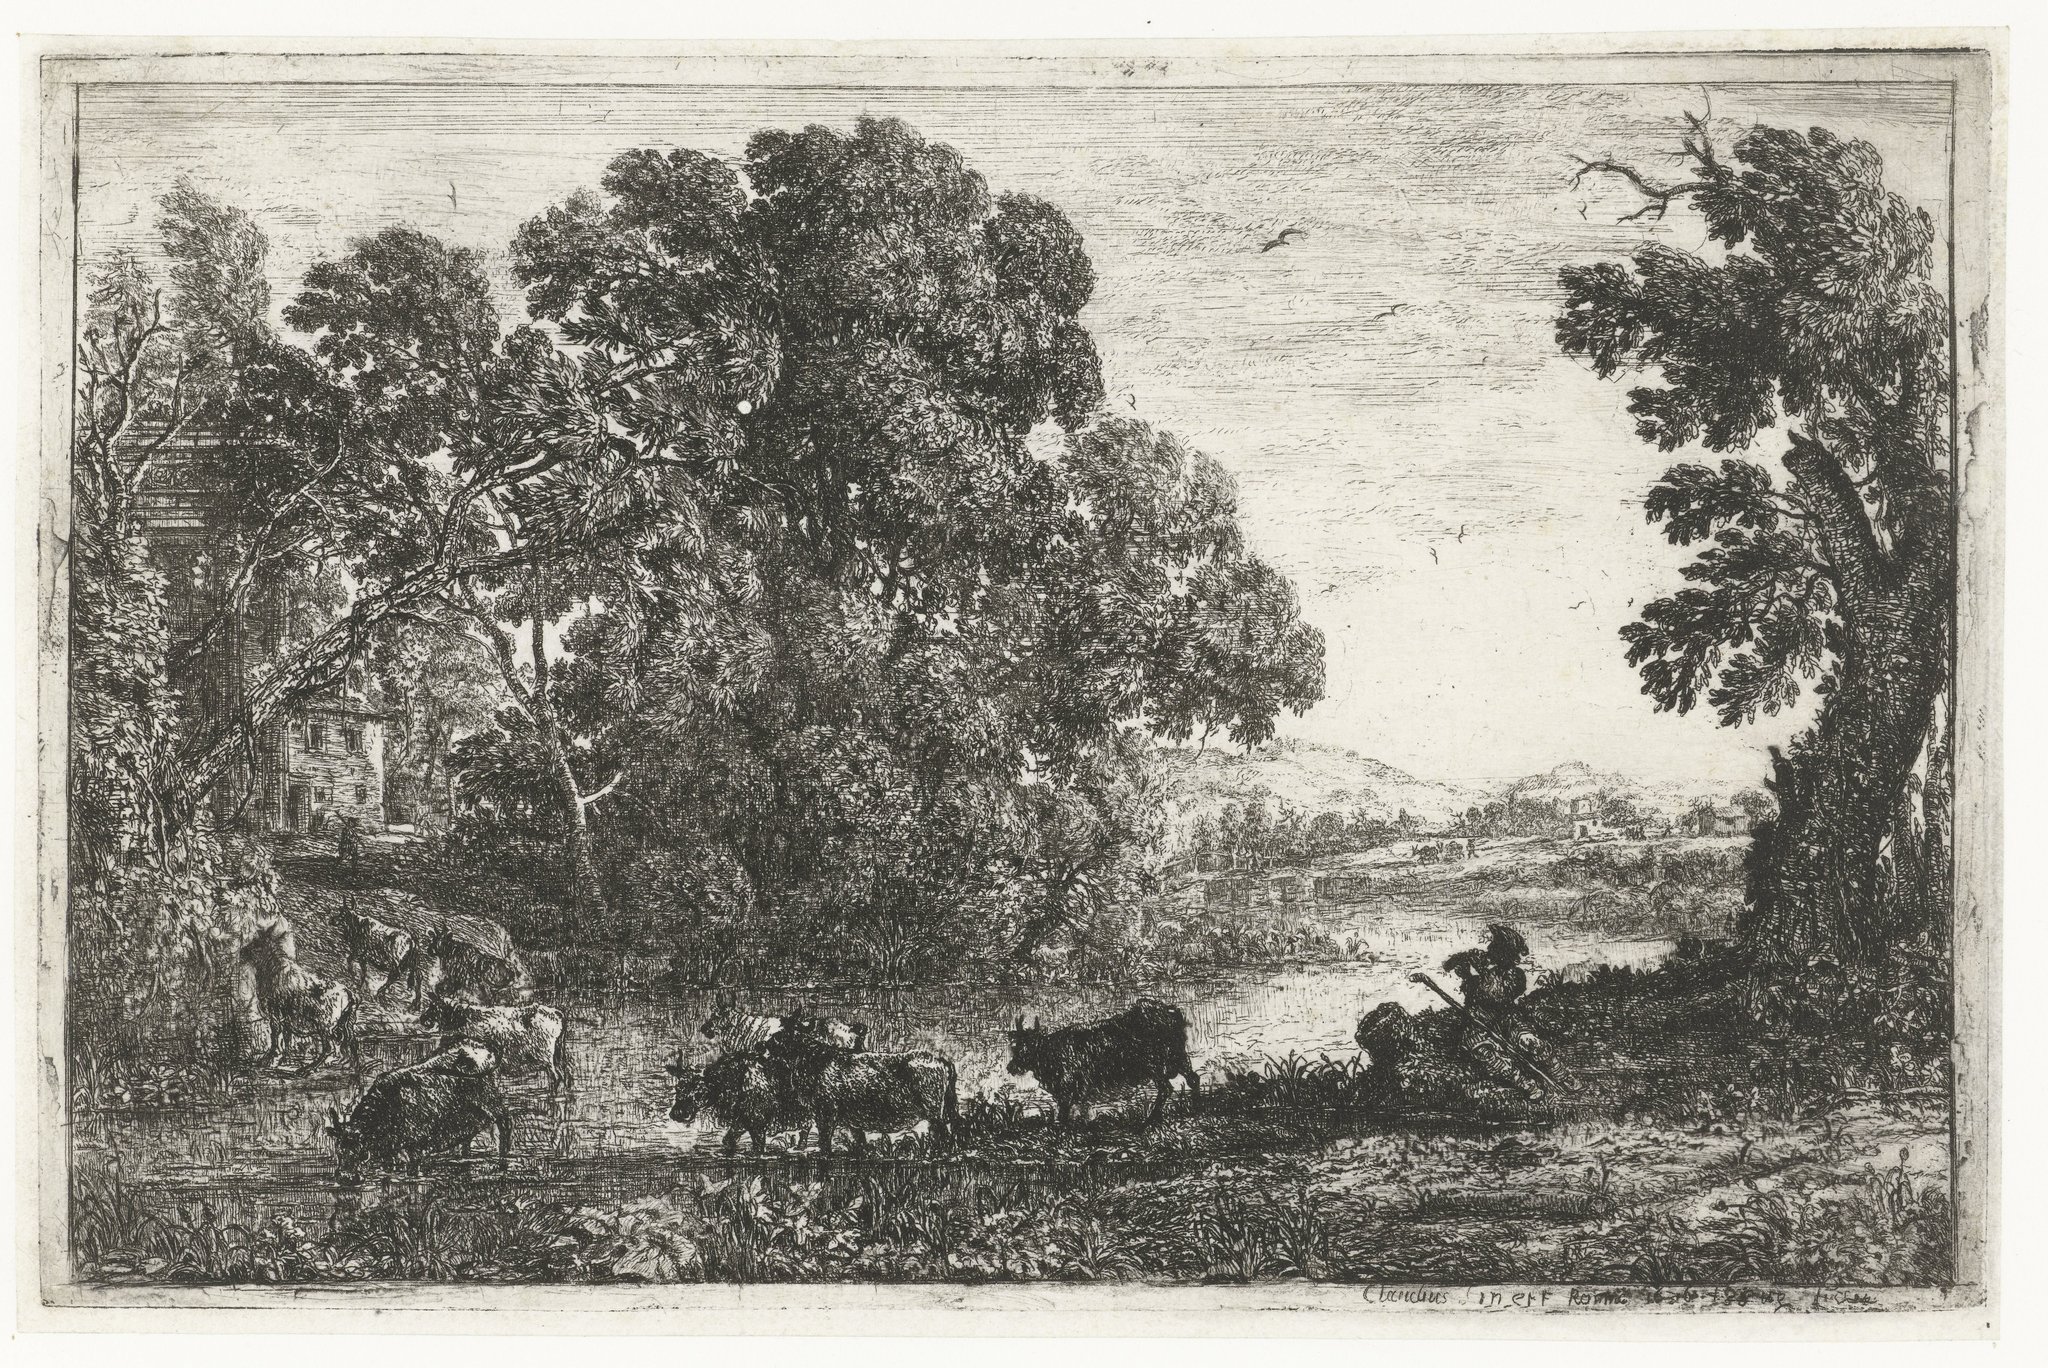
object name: print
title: Le Bouvier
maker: claude lorrain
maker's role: draughtsman, print maker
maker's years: 1604-1682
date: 1636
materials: paper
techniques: etching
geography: rome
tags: crossing a river, herding, herdsman, herdswoman, shepherd, shepherdess, cowherd, etc.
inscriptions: collector's mark: Lugt 240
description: Een kudde koeien waadt door de rivier, de herder gezeten op de oever speelt op een instrument.